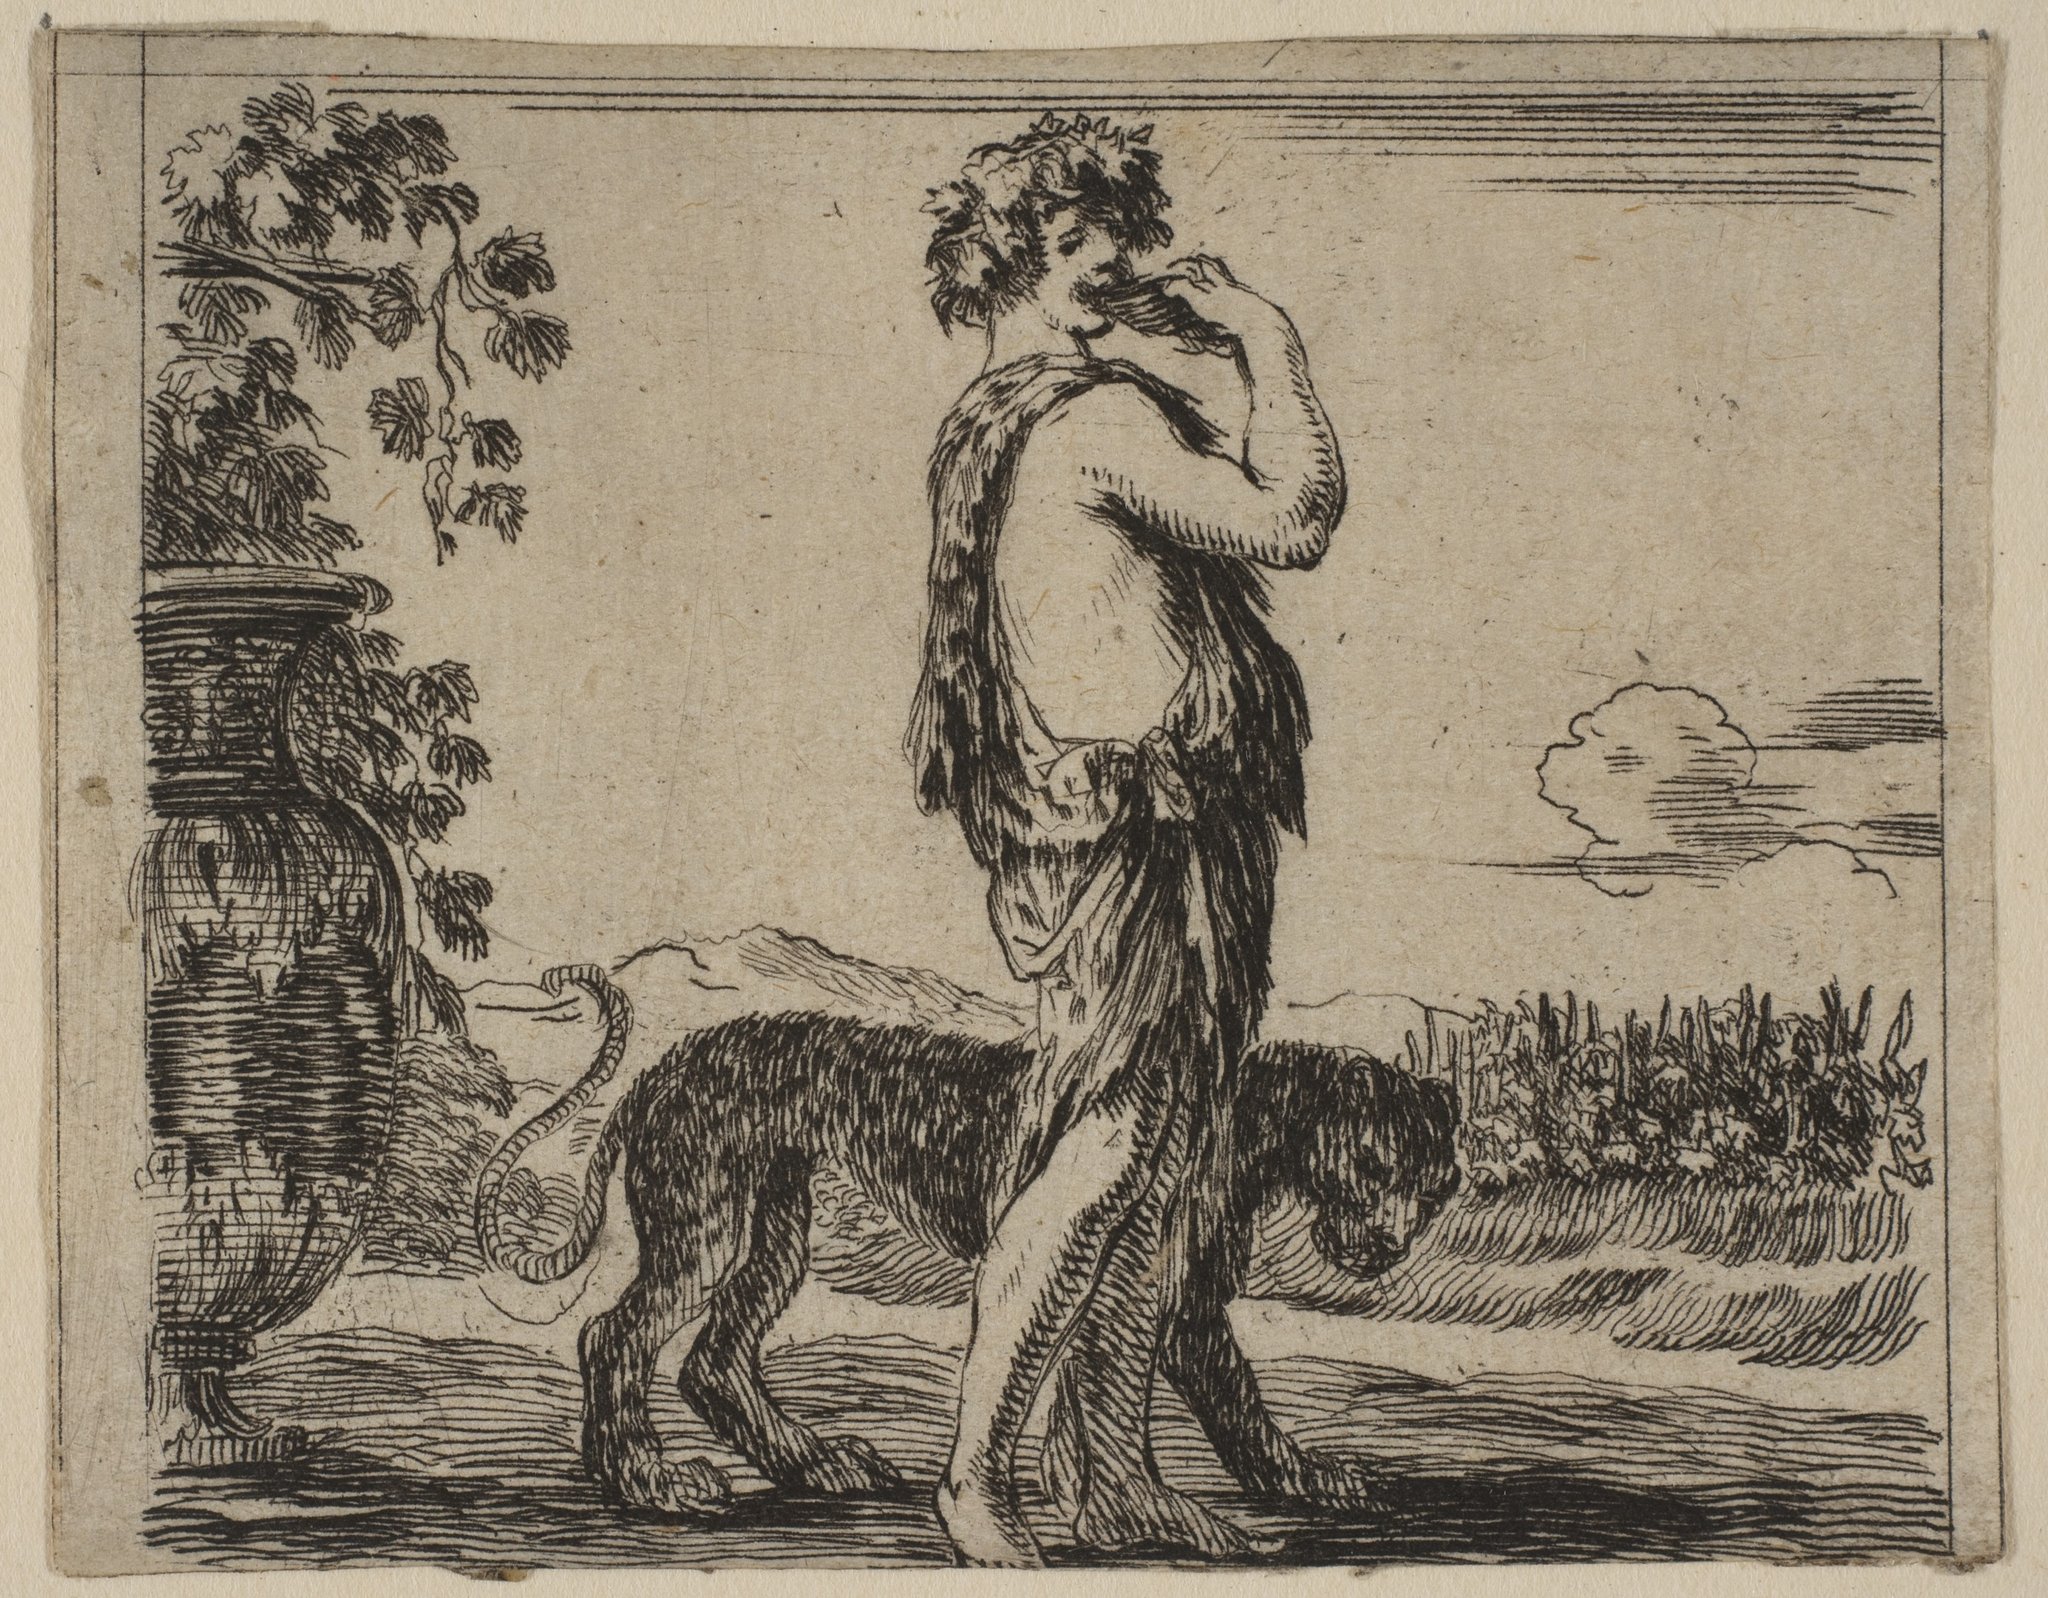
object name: print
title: Bacchus, from 'Game of Mythology' (Jeu de la Mythologie)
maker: stefano della bella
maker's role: artist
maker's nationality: italian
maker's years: 1610-1664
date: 1644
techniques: etching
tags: bacchus,lions